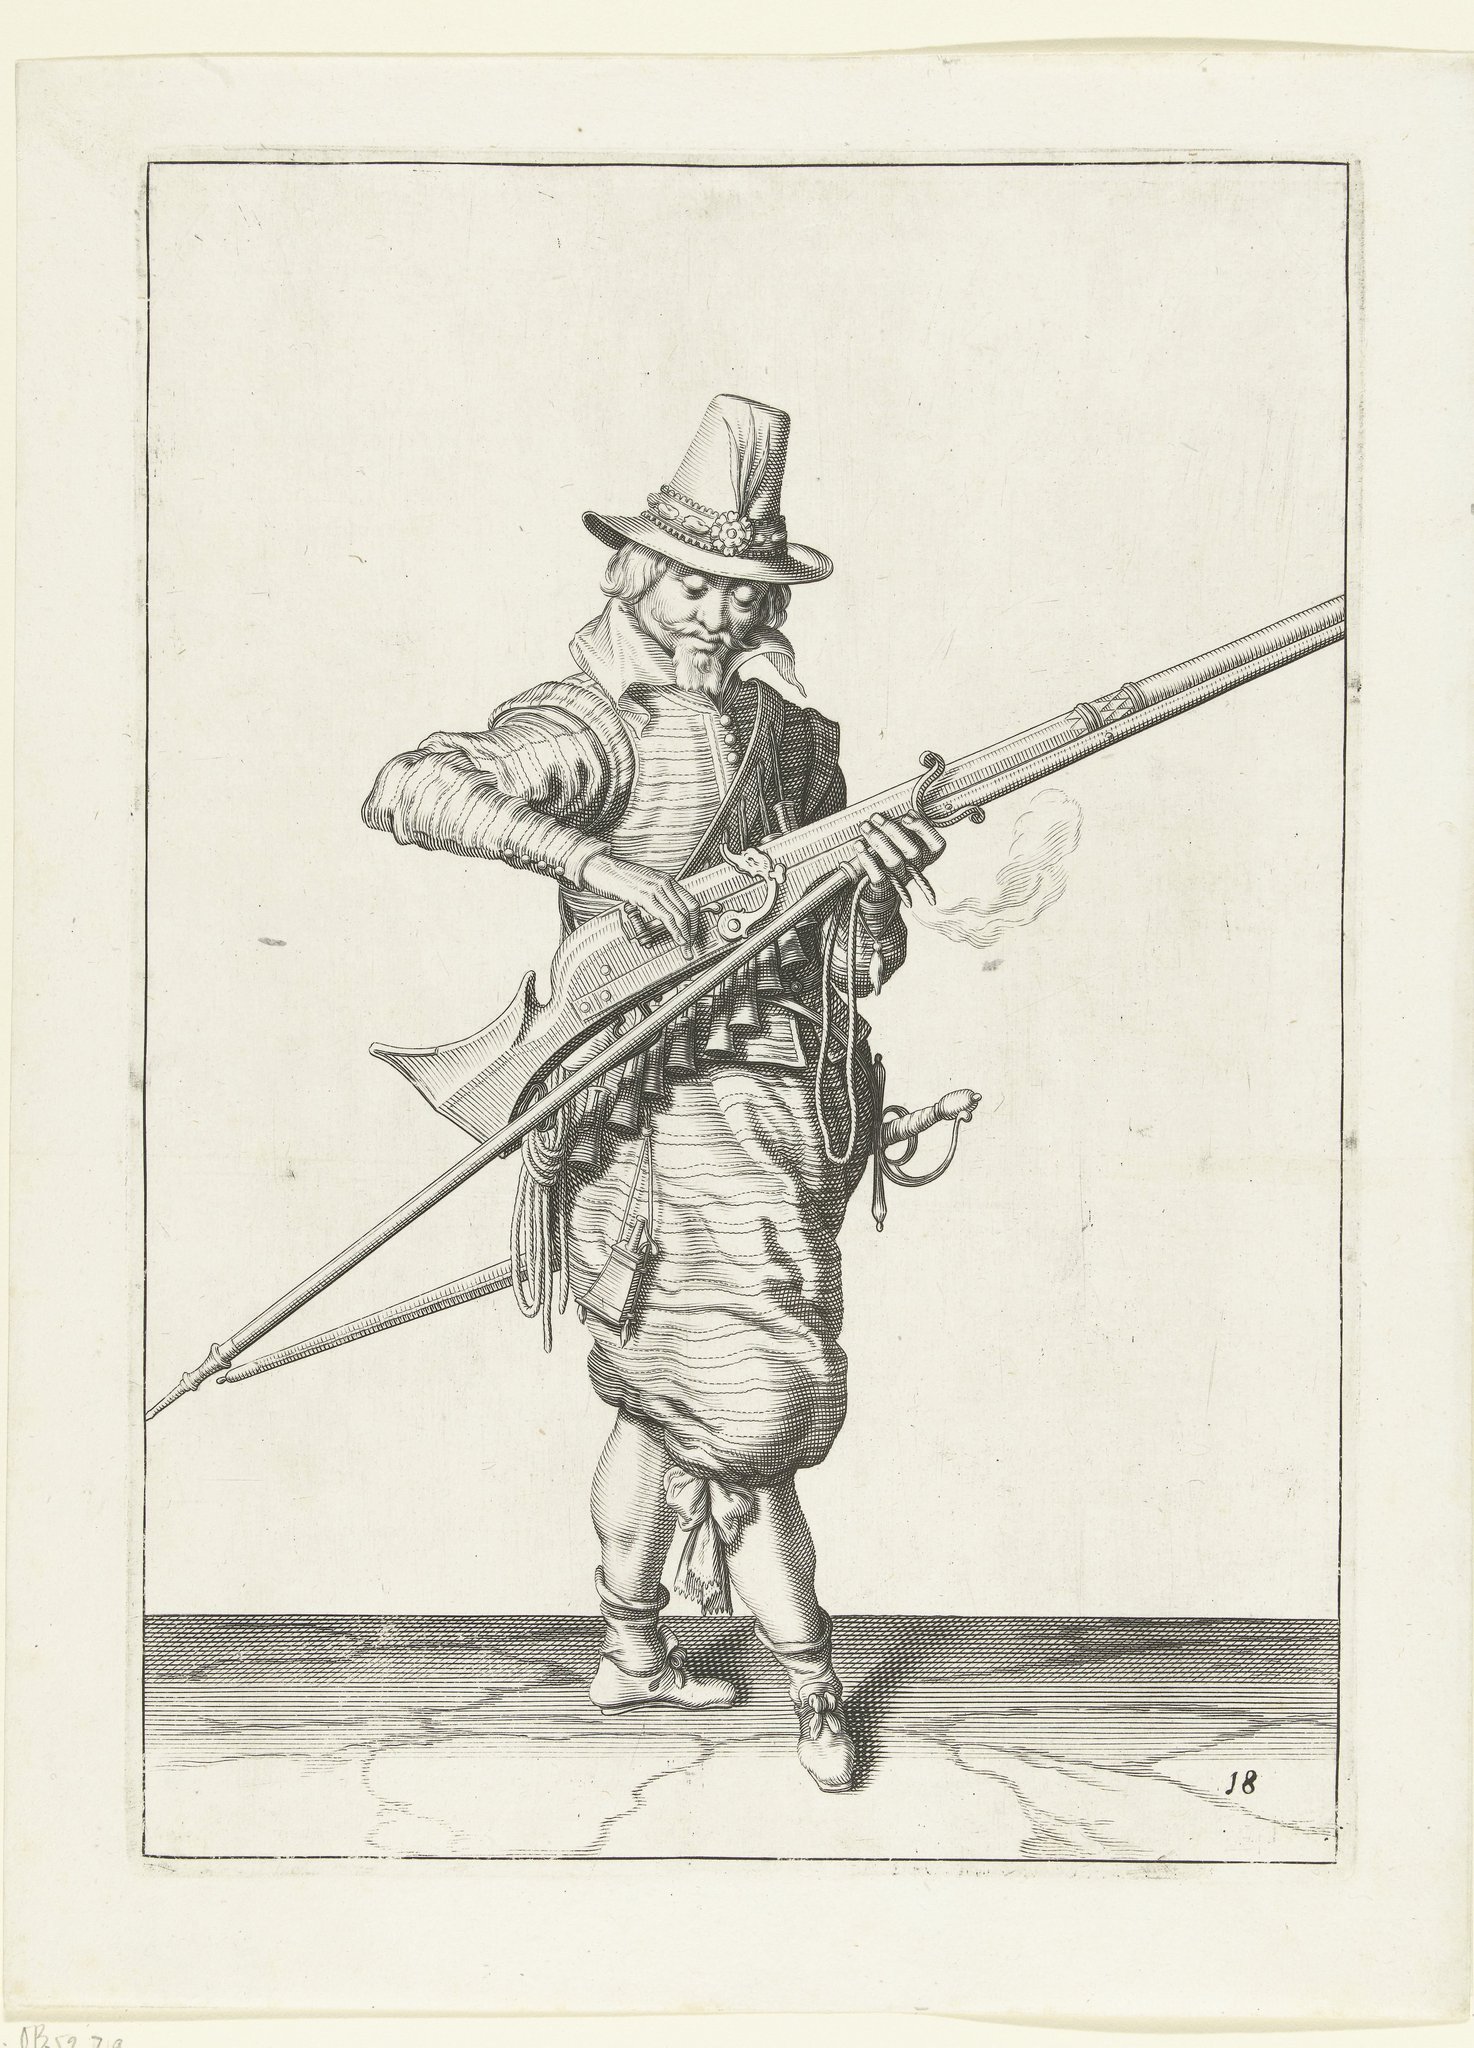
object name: print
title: Wapenhandelinghe van Roers Musquetten ende Spiessen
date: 1597-1607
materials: paper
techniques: engraving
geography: netherlands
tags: manoeuvre ~ military training, firearms: rifle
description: Een soldaat, ten voeten uit, naar rechts, die met zijn rechterhand de pan (het kruitreservoir) van zijn musket (een bepaald type vuurwapen) sluit. In zijn linkerhand behalve het musket ook een furket (musketvork) en een brandende lont. Deze prent is onderdeel van de reeks van 43 genummerde prenten van musketiers uit de Wapenhandelinghe.